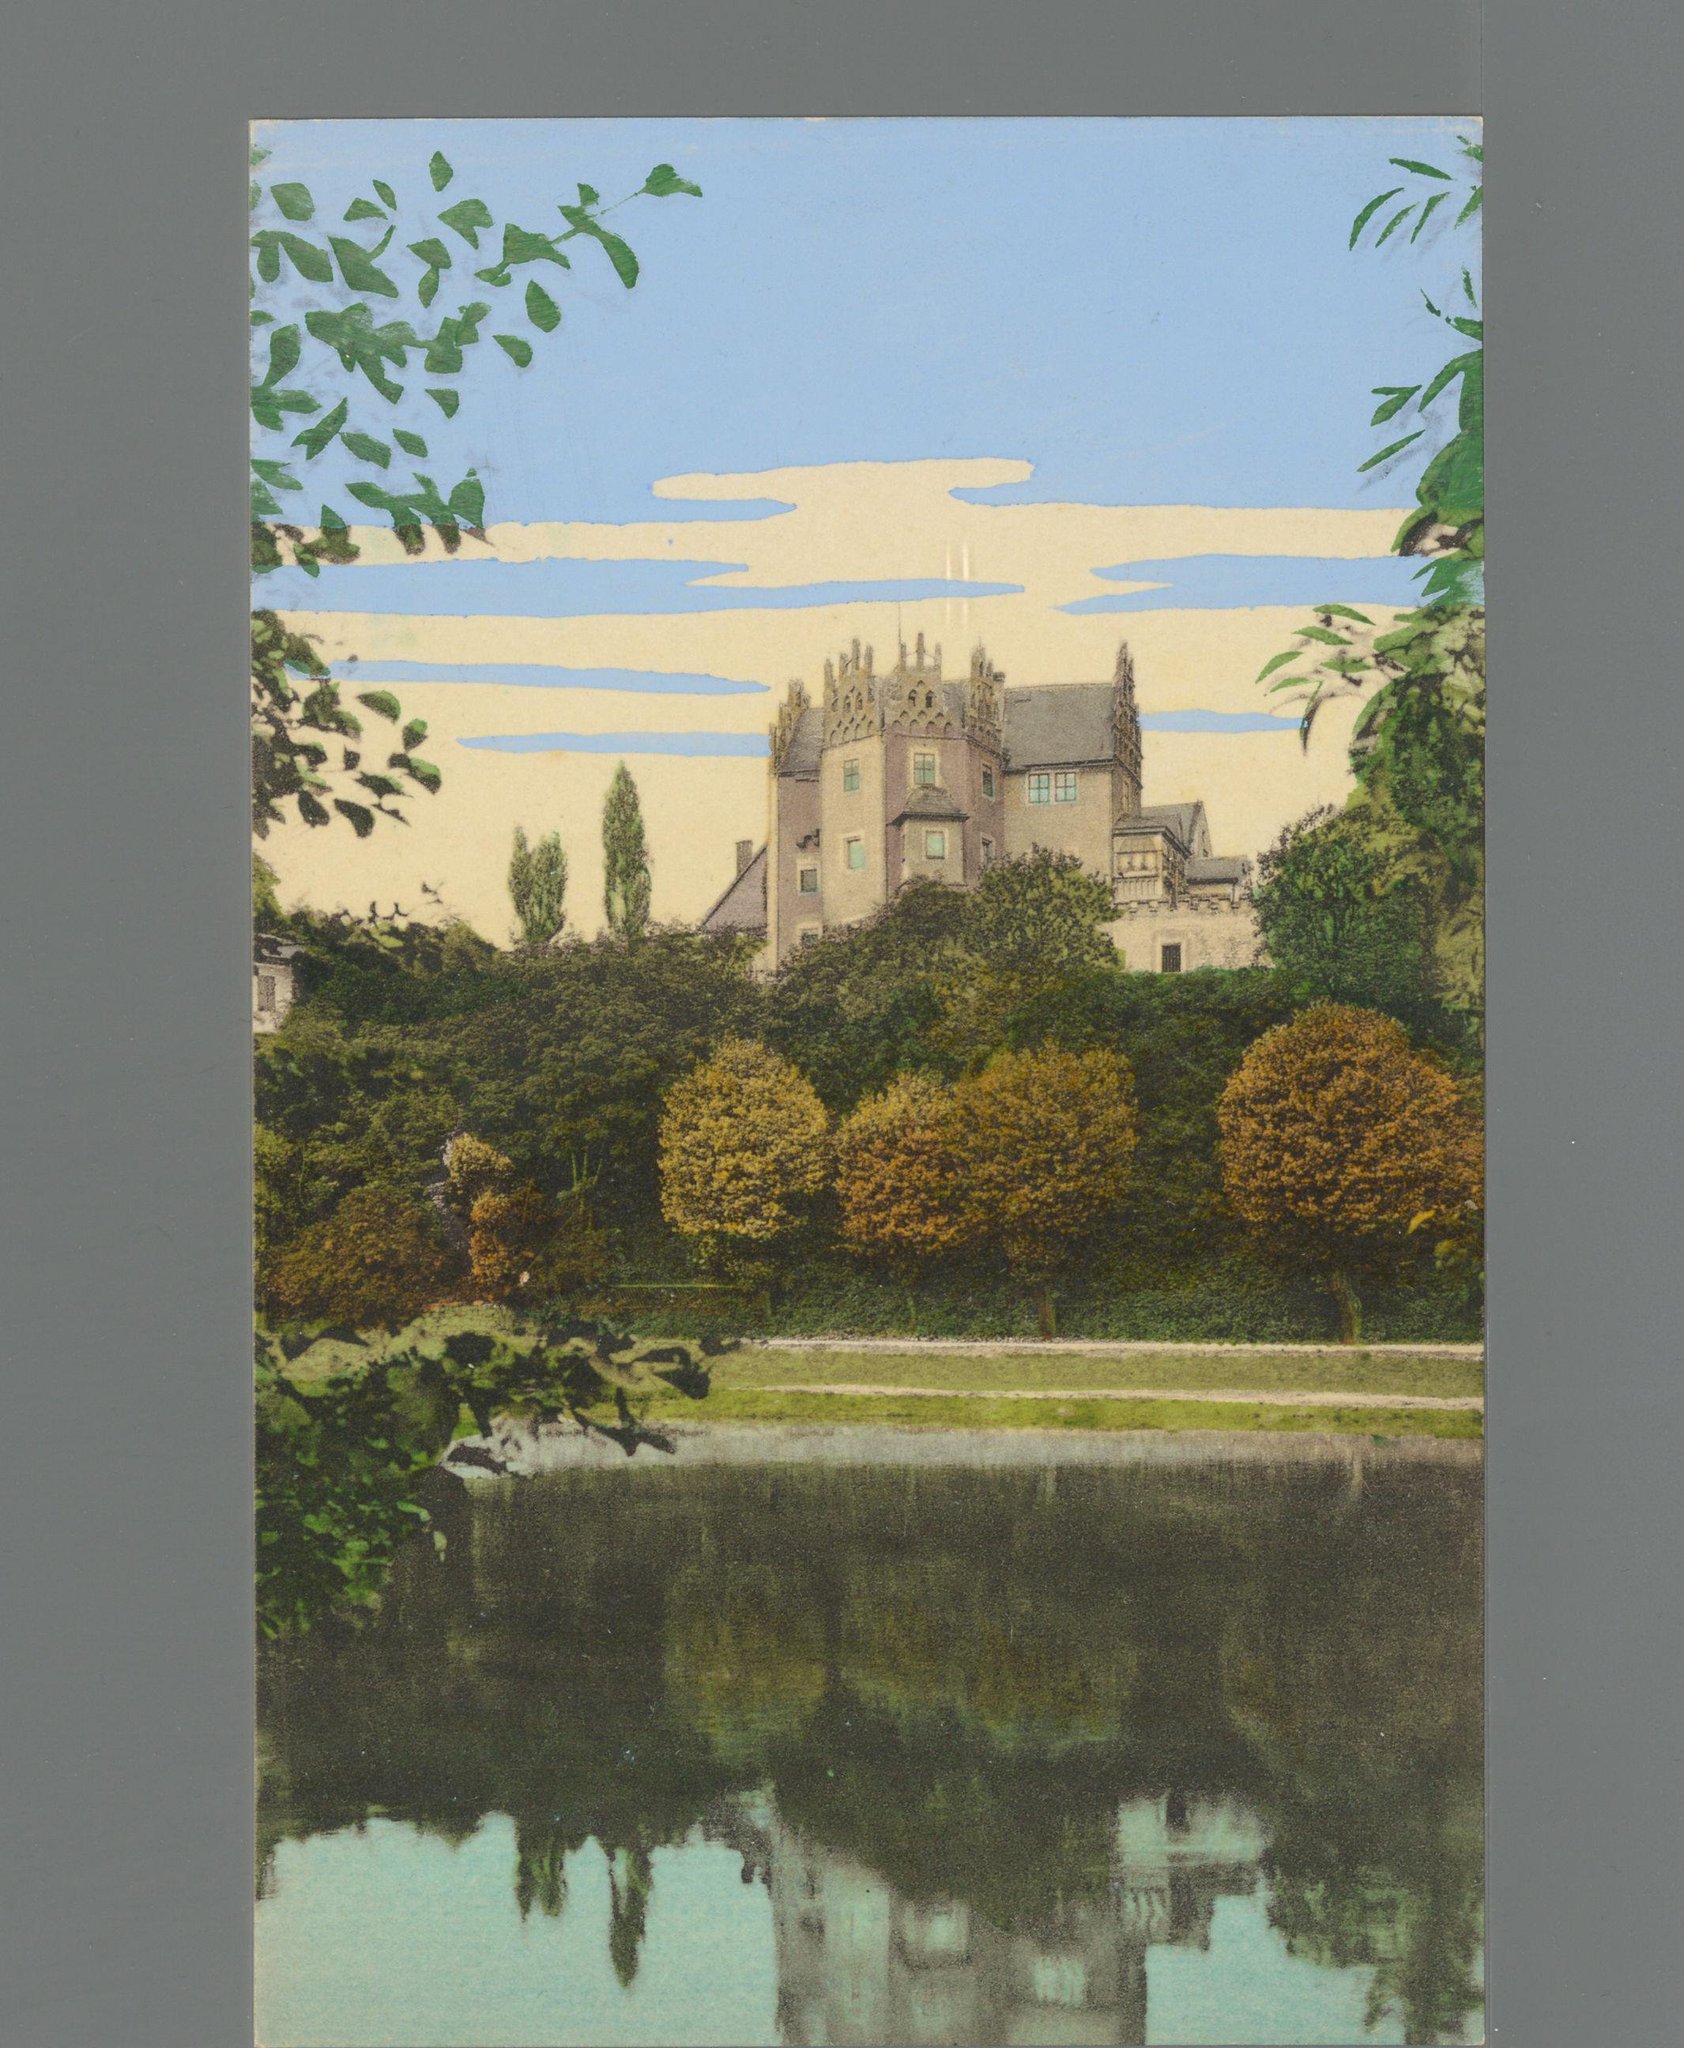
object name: photomechanical print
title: Saalfeld a. S. Schloss Kitzerstein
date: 1905-1930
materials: cardboard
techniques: photograph, lithograph, hand coloring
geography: saalfeld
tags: castle, river